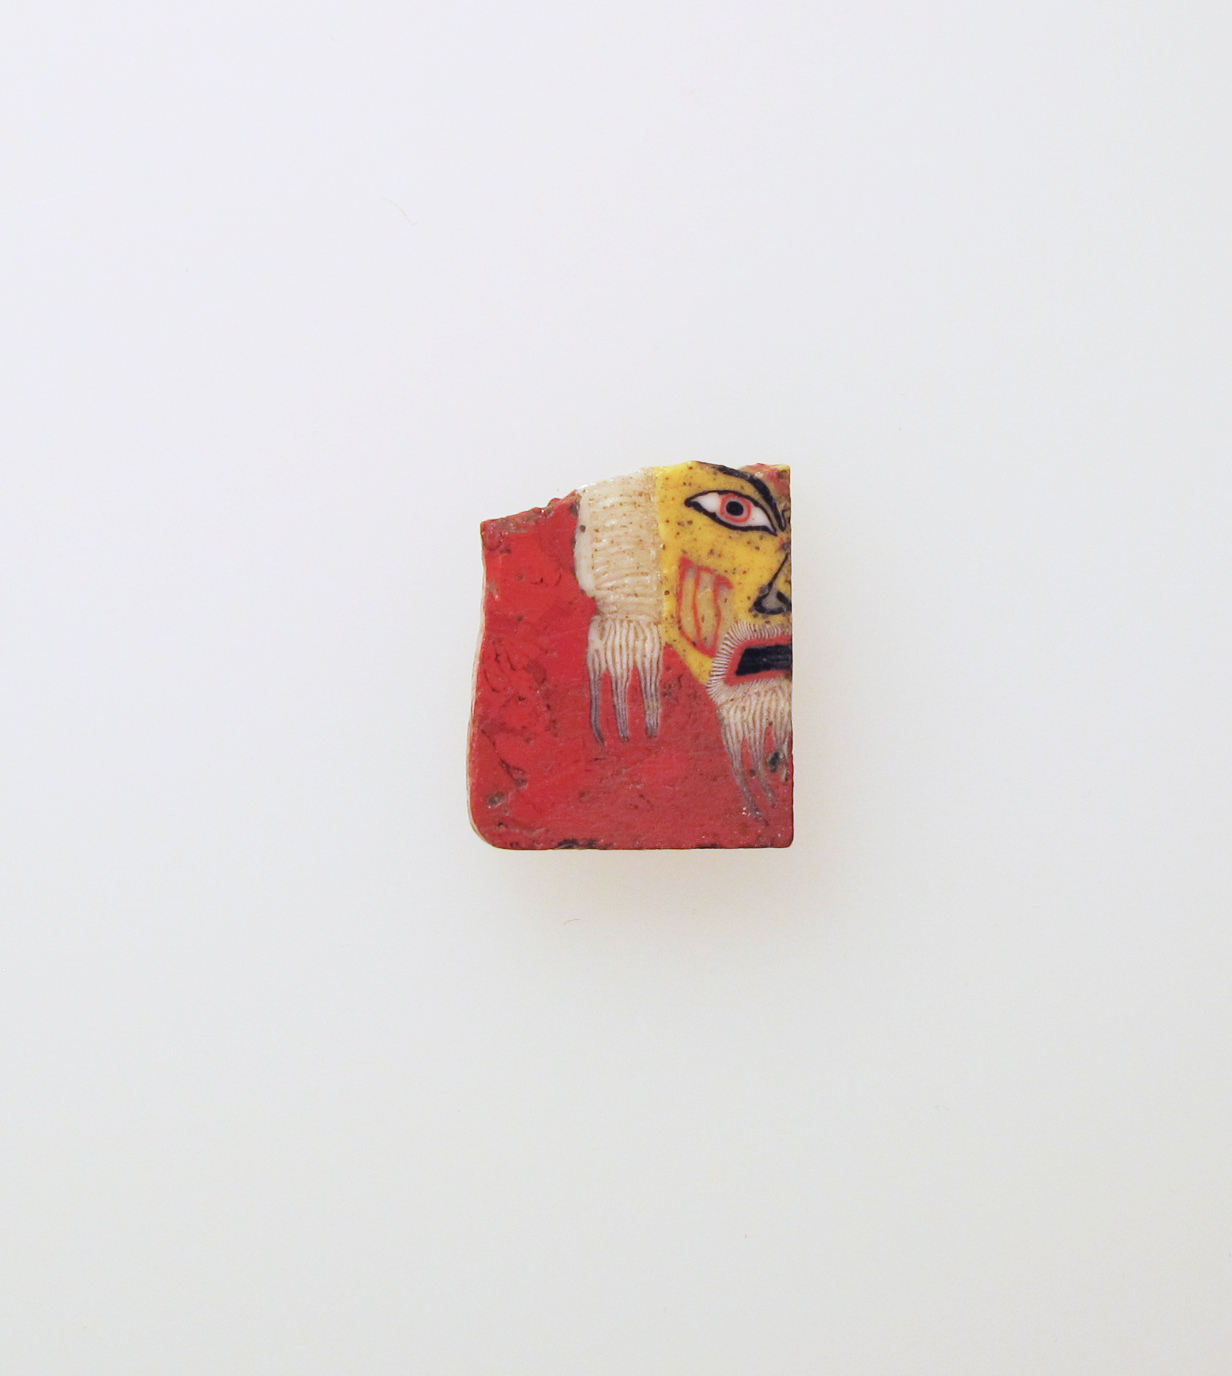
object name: mosaic plaque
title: Mosaic glass inlay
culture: roman, egyptian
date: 100 BCE-100 CE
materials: glass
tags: masks